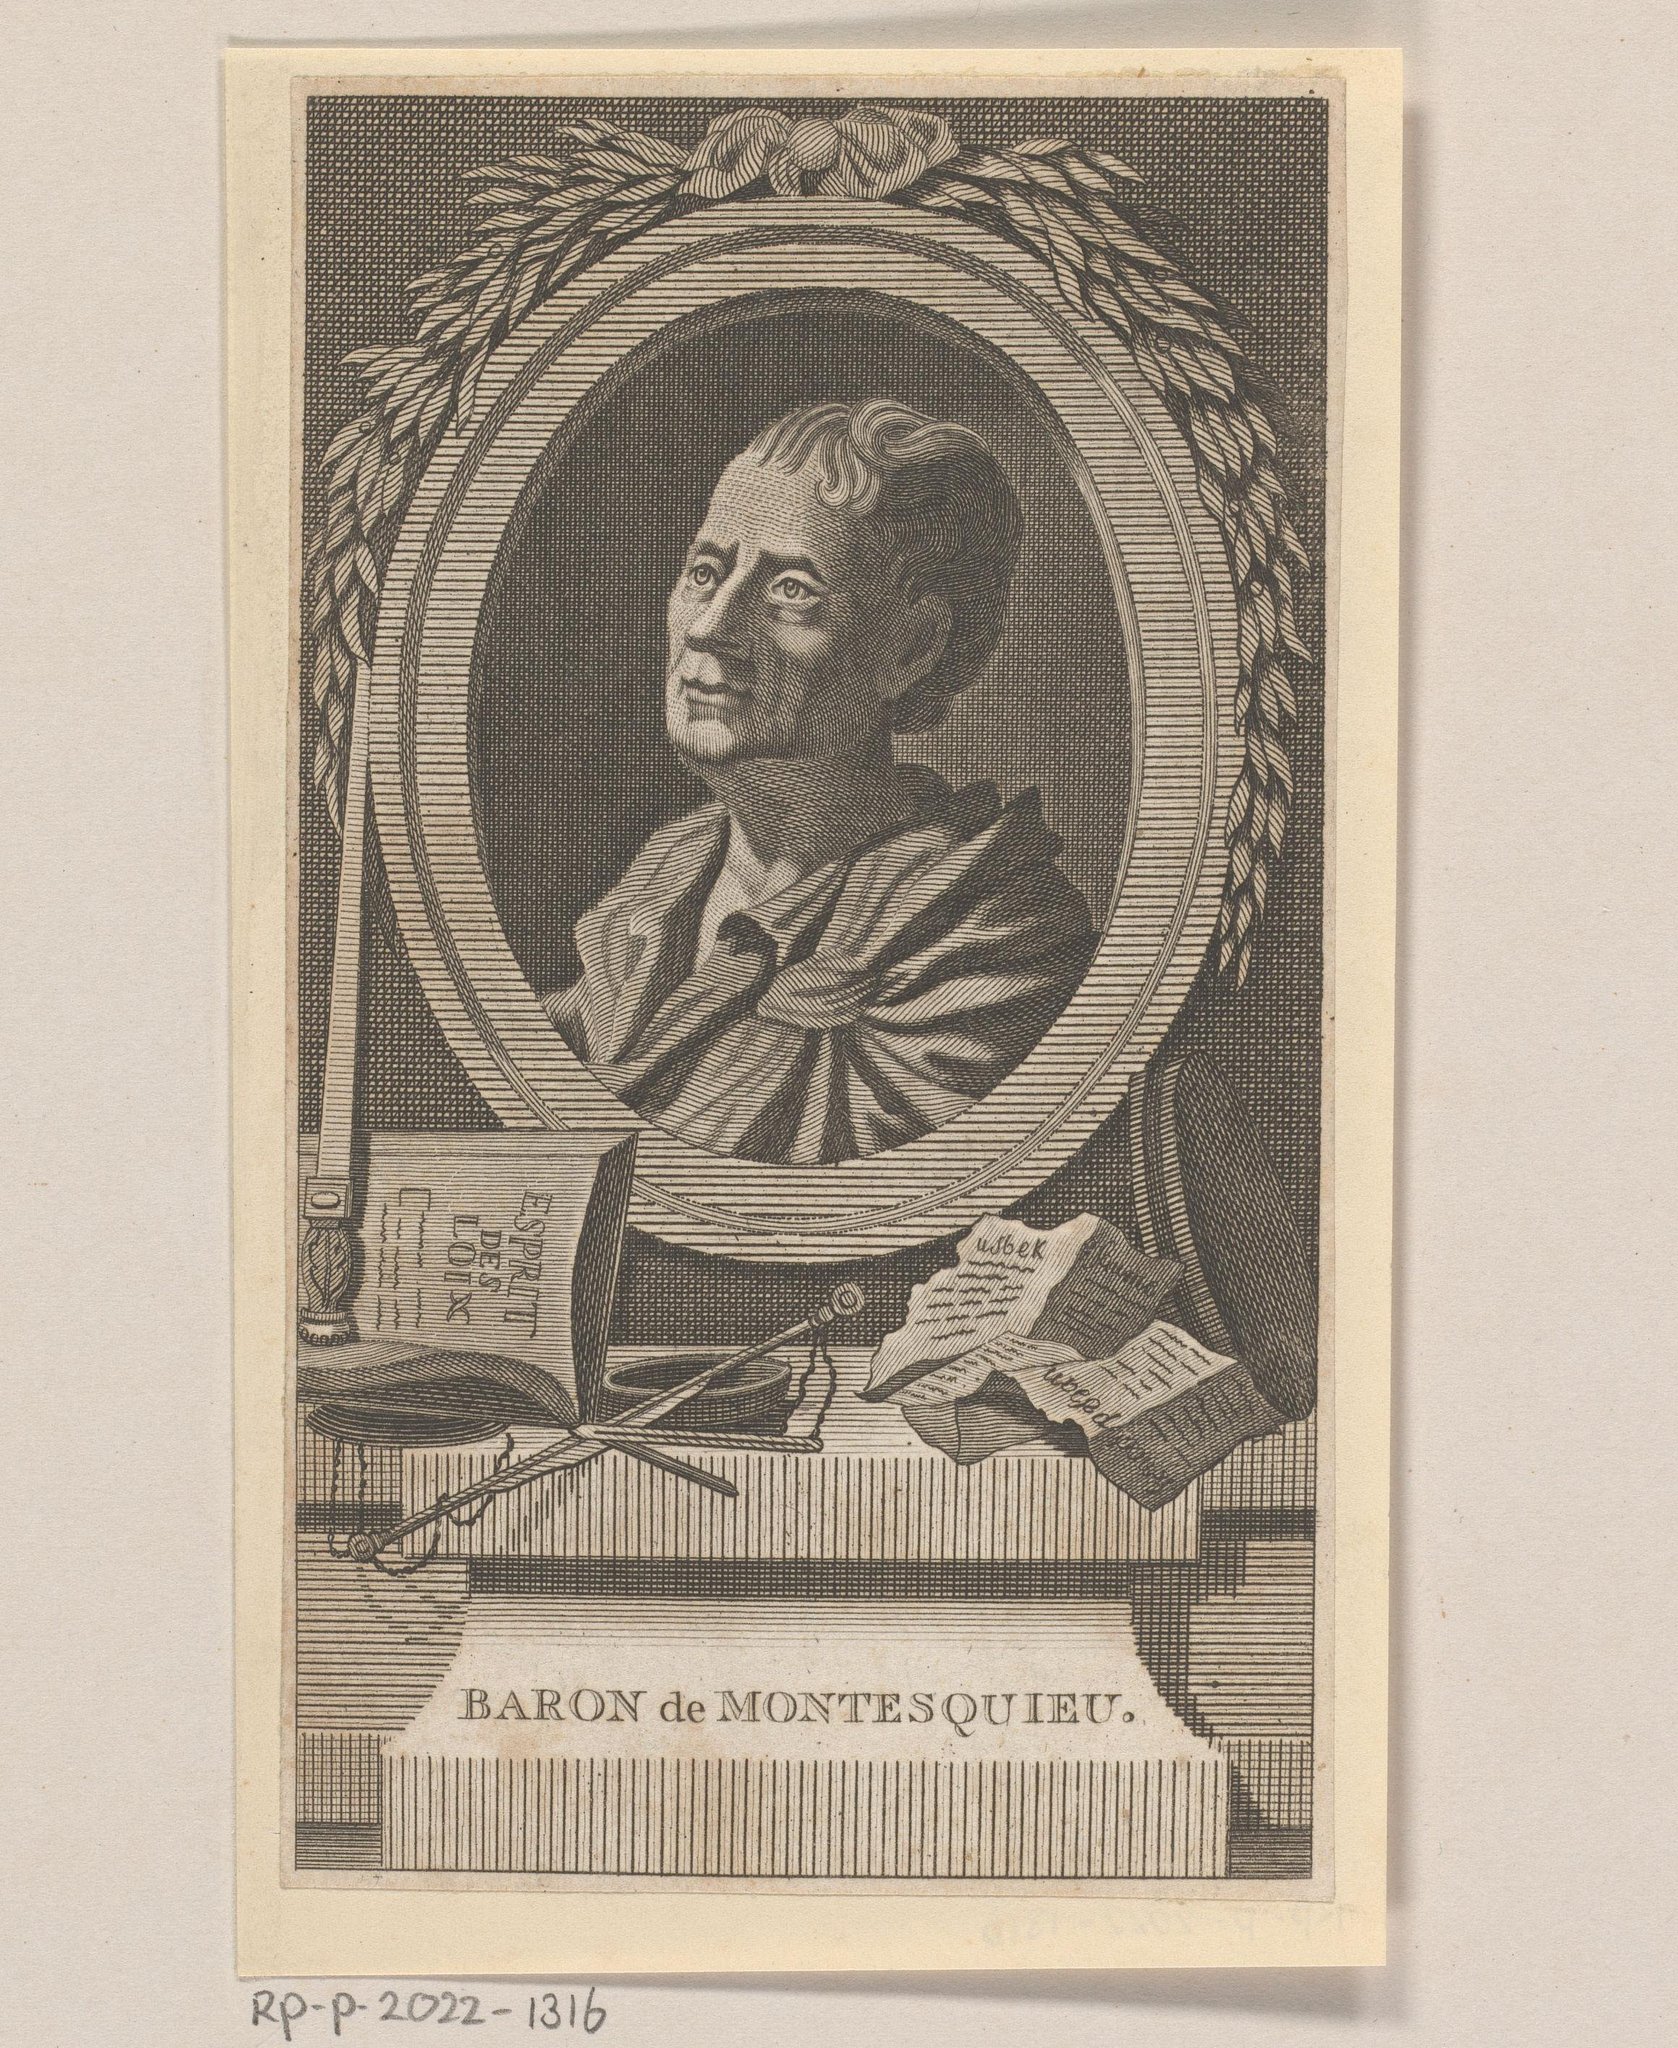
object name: print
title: Baron de Montesquieu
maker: Anonymous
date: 1730-1850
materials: paper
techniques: engraving, etching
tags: paris, scholar, philosopher, historical persons